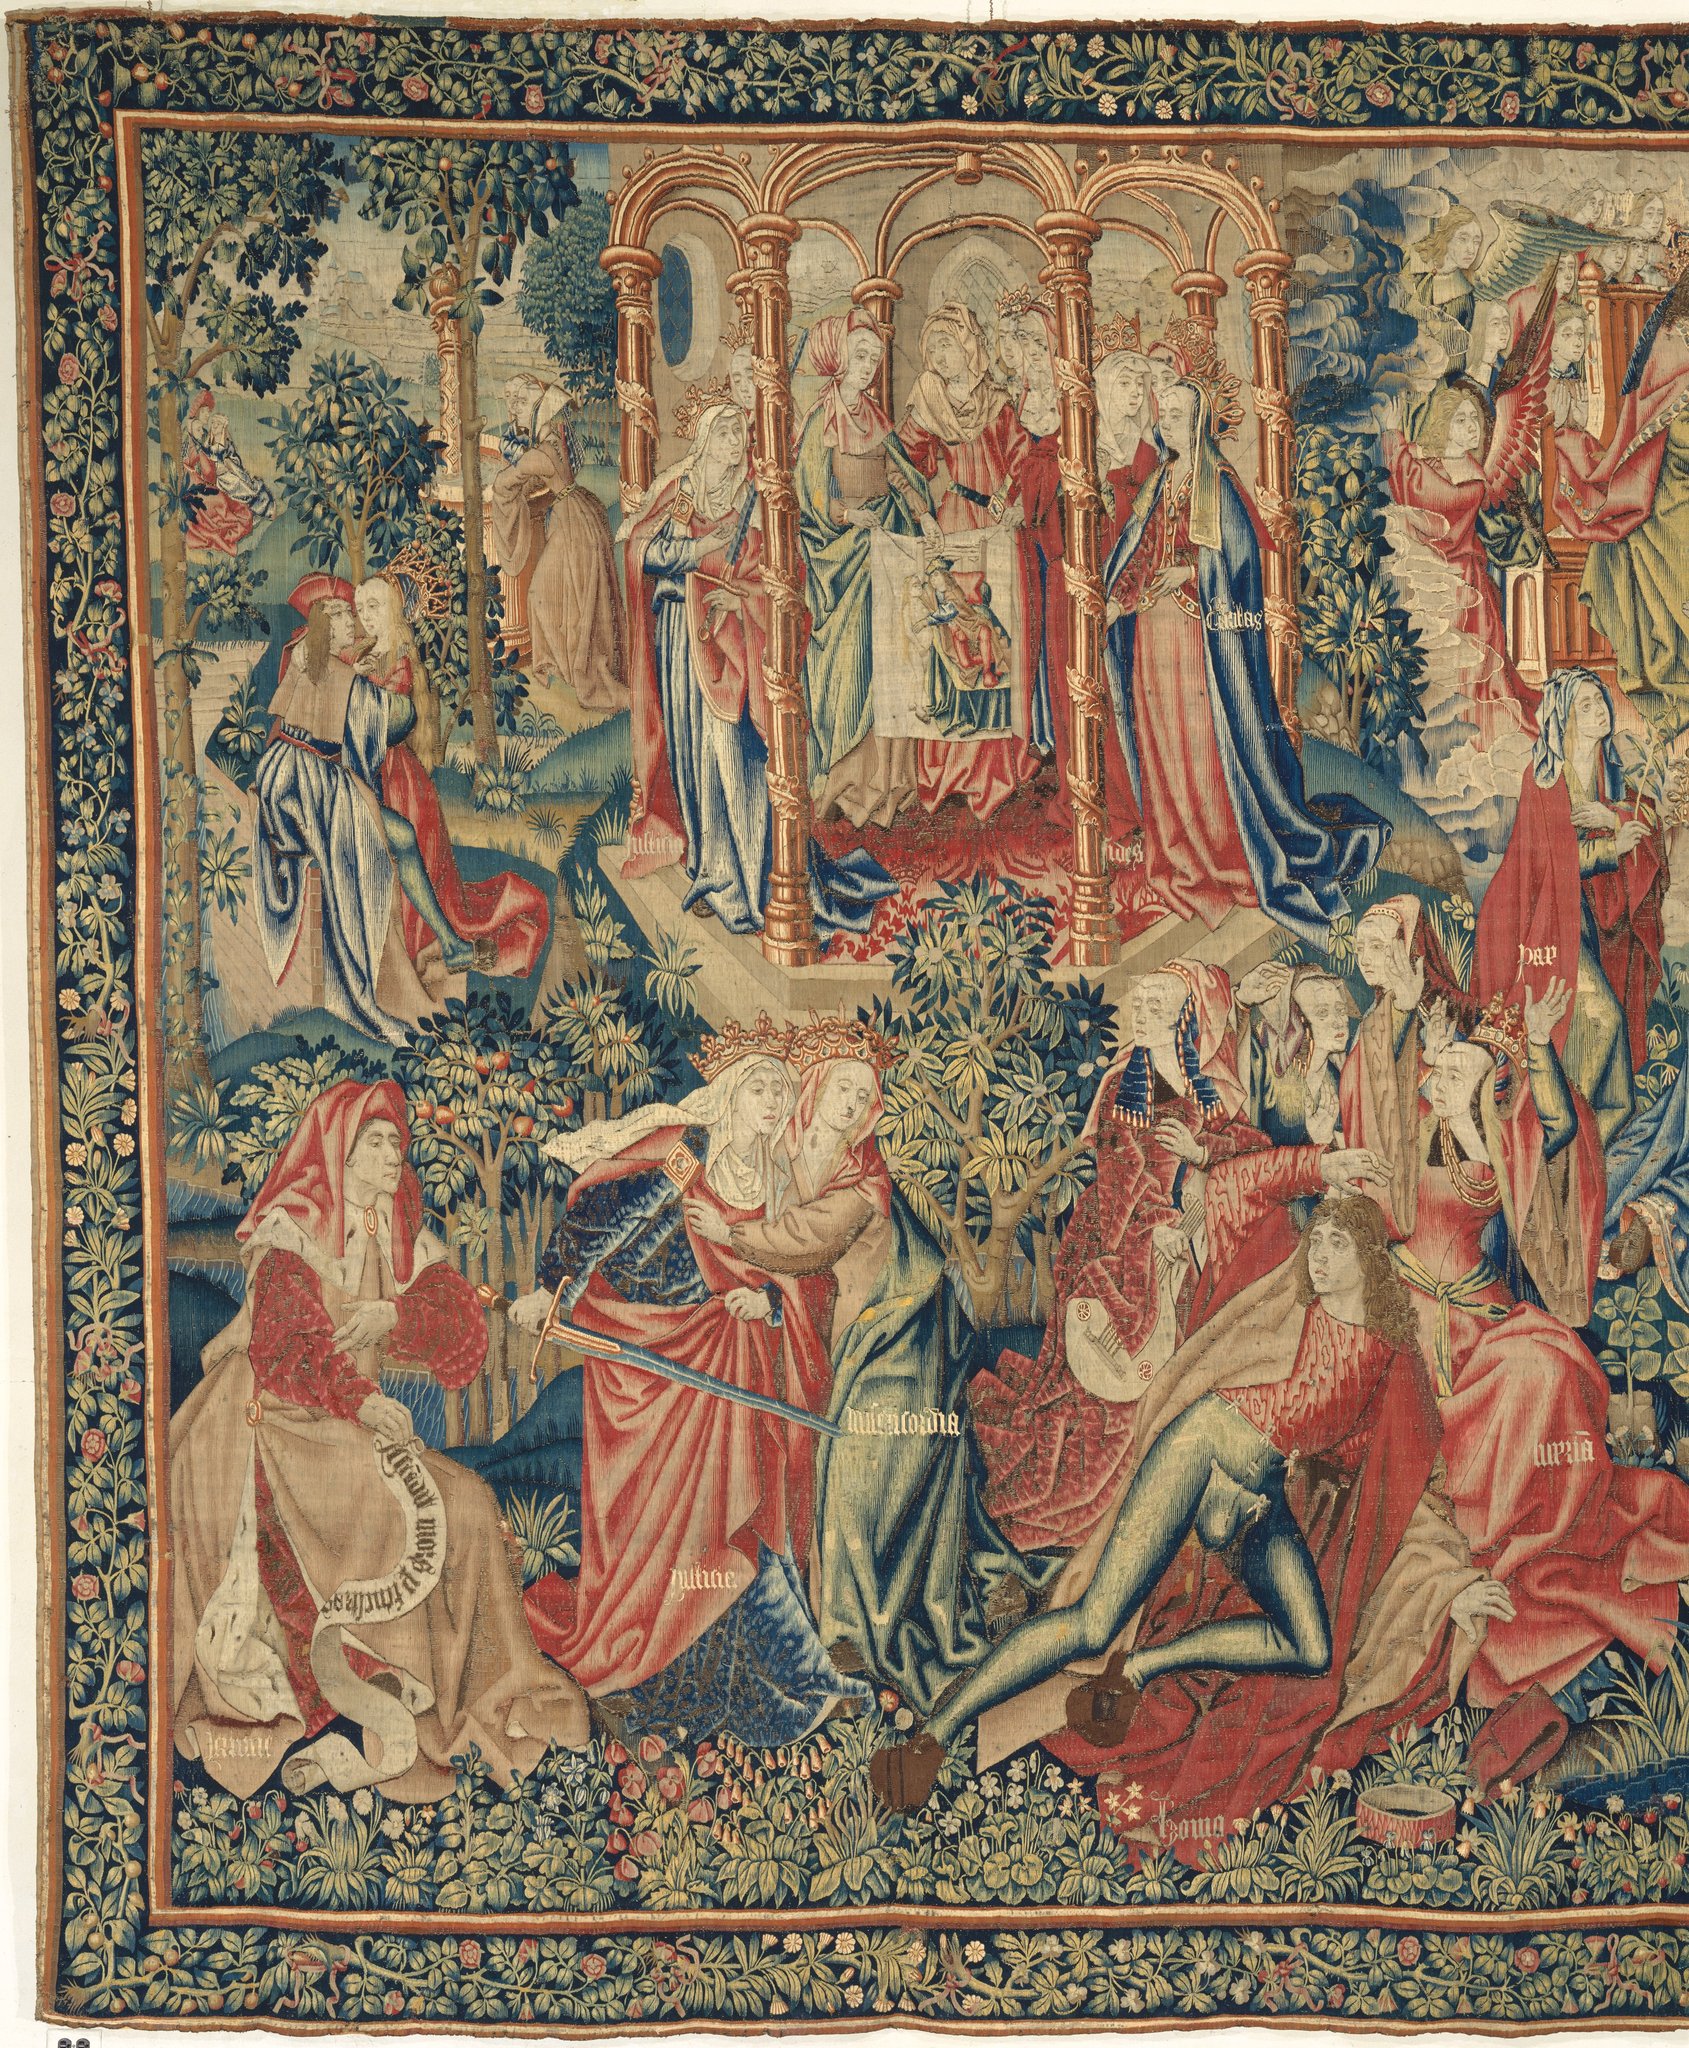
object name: tapestry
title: Peace and Mercy Win the Promise of Redemption for Man (Episode from The Story of the Redemption of Man)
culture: south netherlandish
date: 1500-1520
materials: silk, wool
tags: swords,men,women,christ